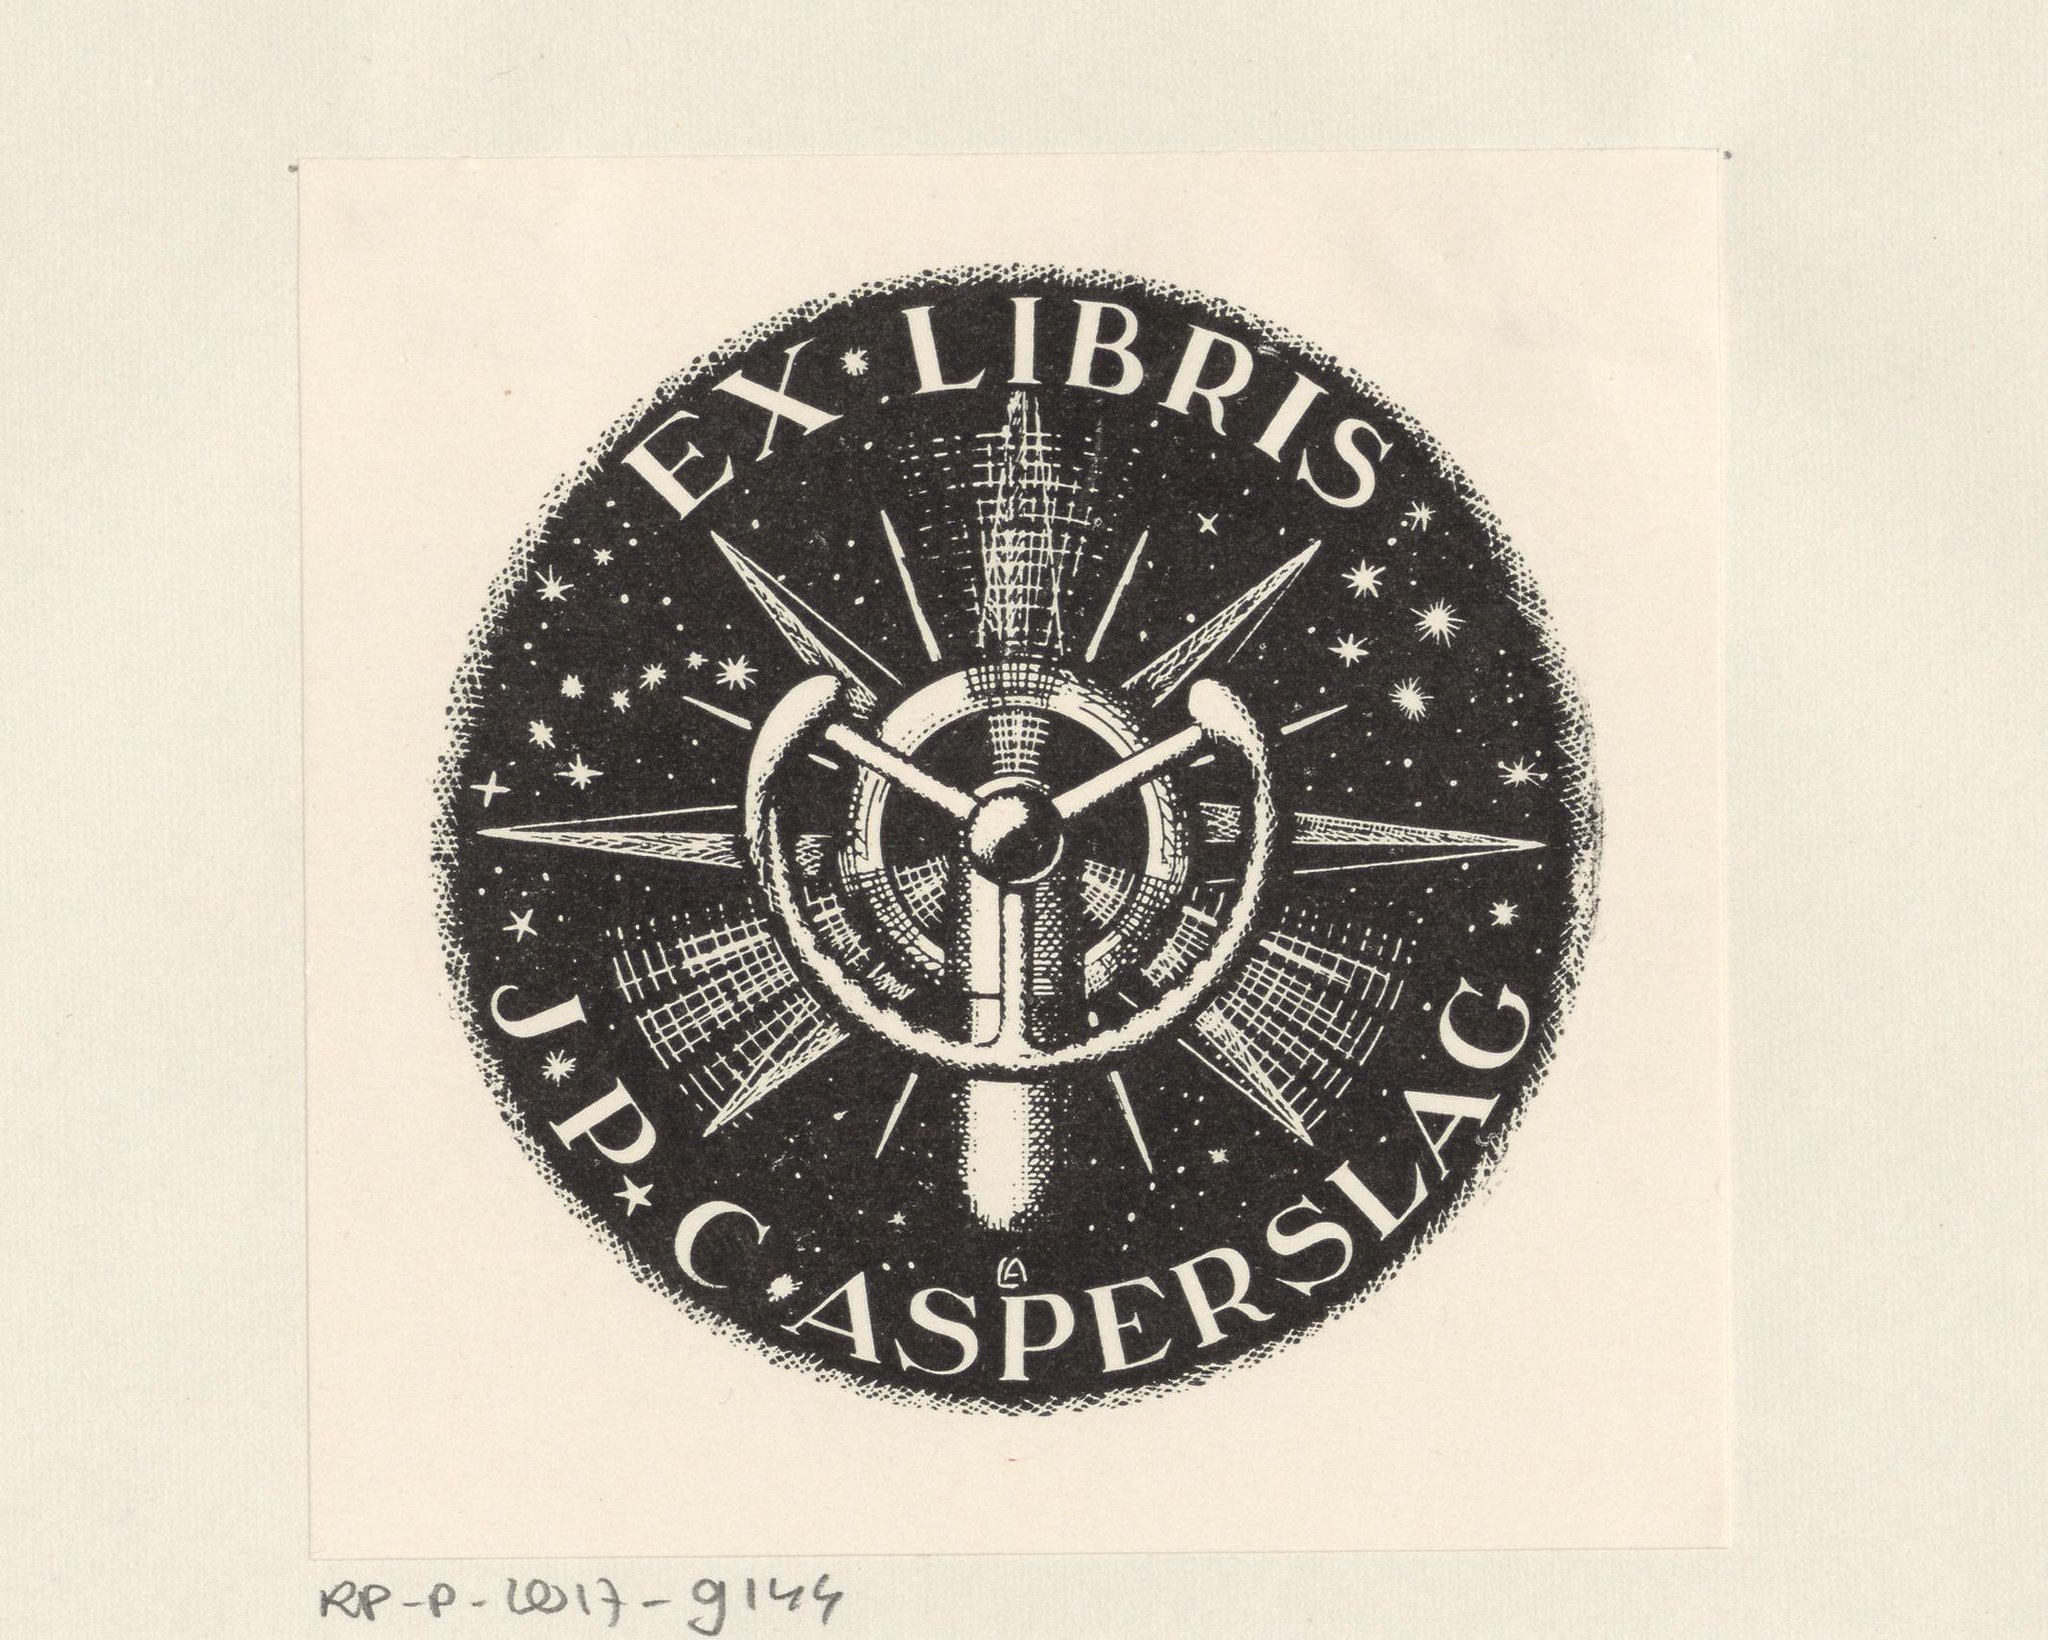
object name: bookplate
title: Ex libris van J.P.C. Asperslag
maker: louis m.j. jr. asperslag (lou)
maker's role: print maker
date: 1953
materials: paper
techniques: woodcut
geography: belgium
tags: aircraft, aeroplane, stars, compass